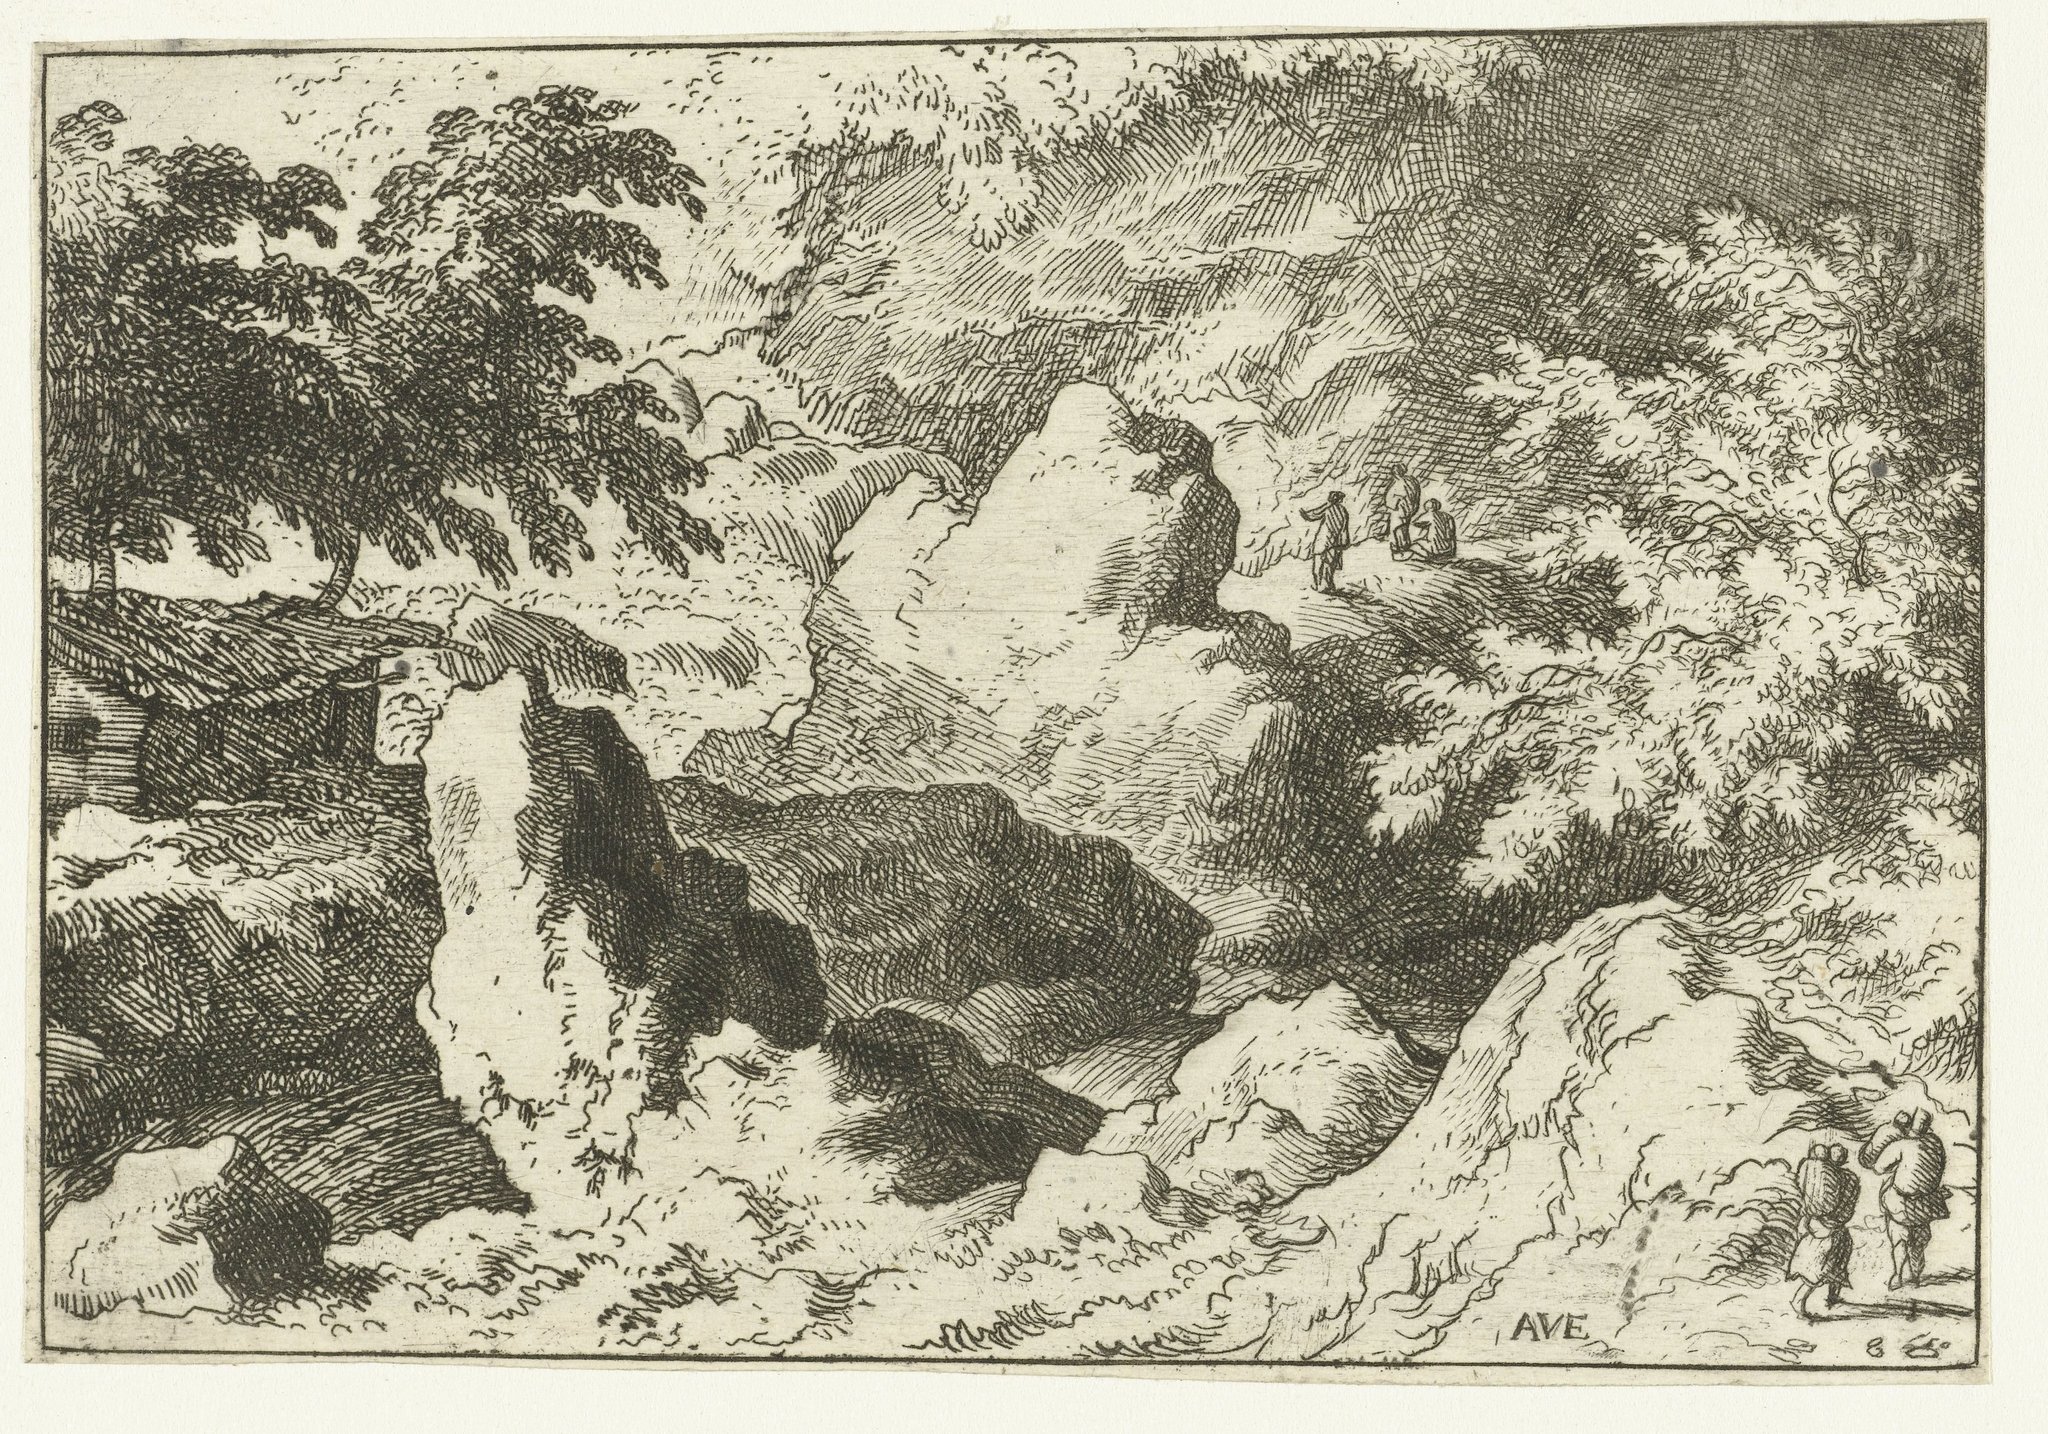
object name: print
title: Landschap met drie mannen op een rots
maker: allaert van everdingen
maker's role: draughtsman, painter, print maker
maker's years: 1621-1675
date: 1631-1675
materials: paper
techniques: etching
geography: netherlands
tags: rock-formations (+ landscape with figures, staffage)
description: Bergachtig landschap met een vervallen hut onder twee bomen. Op de voorgrond een man en een vrouw en op de achtergrond drie personen op een rots.